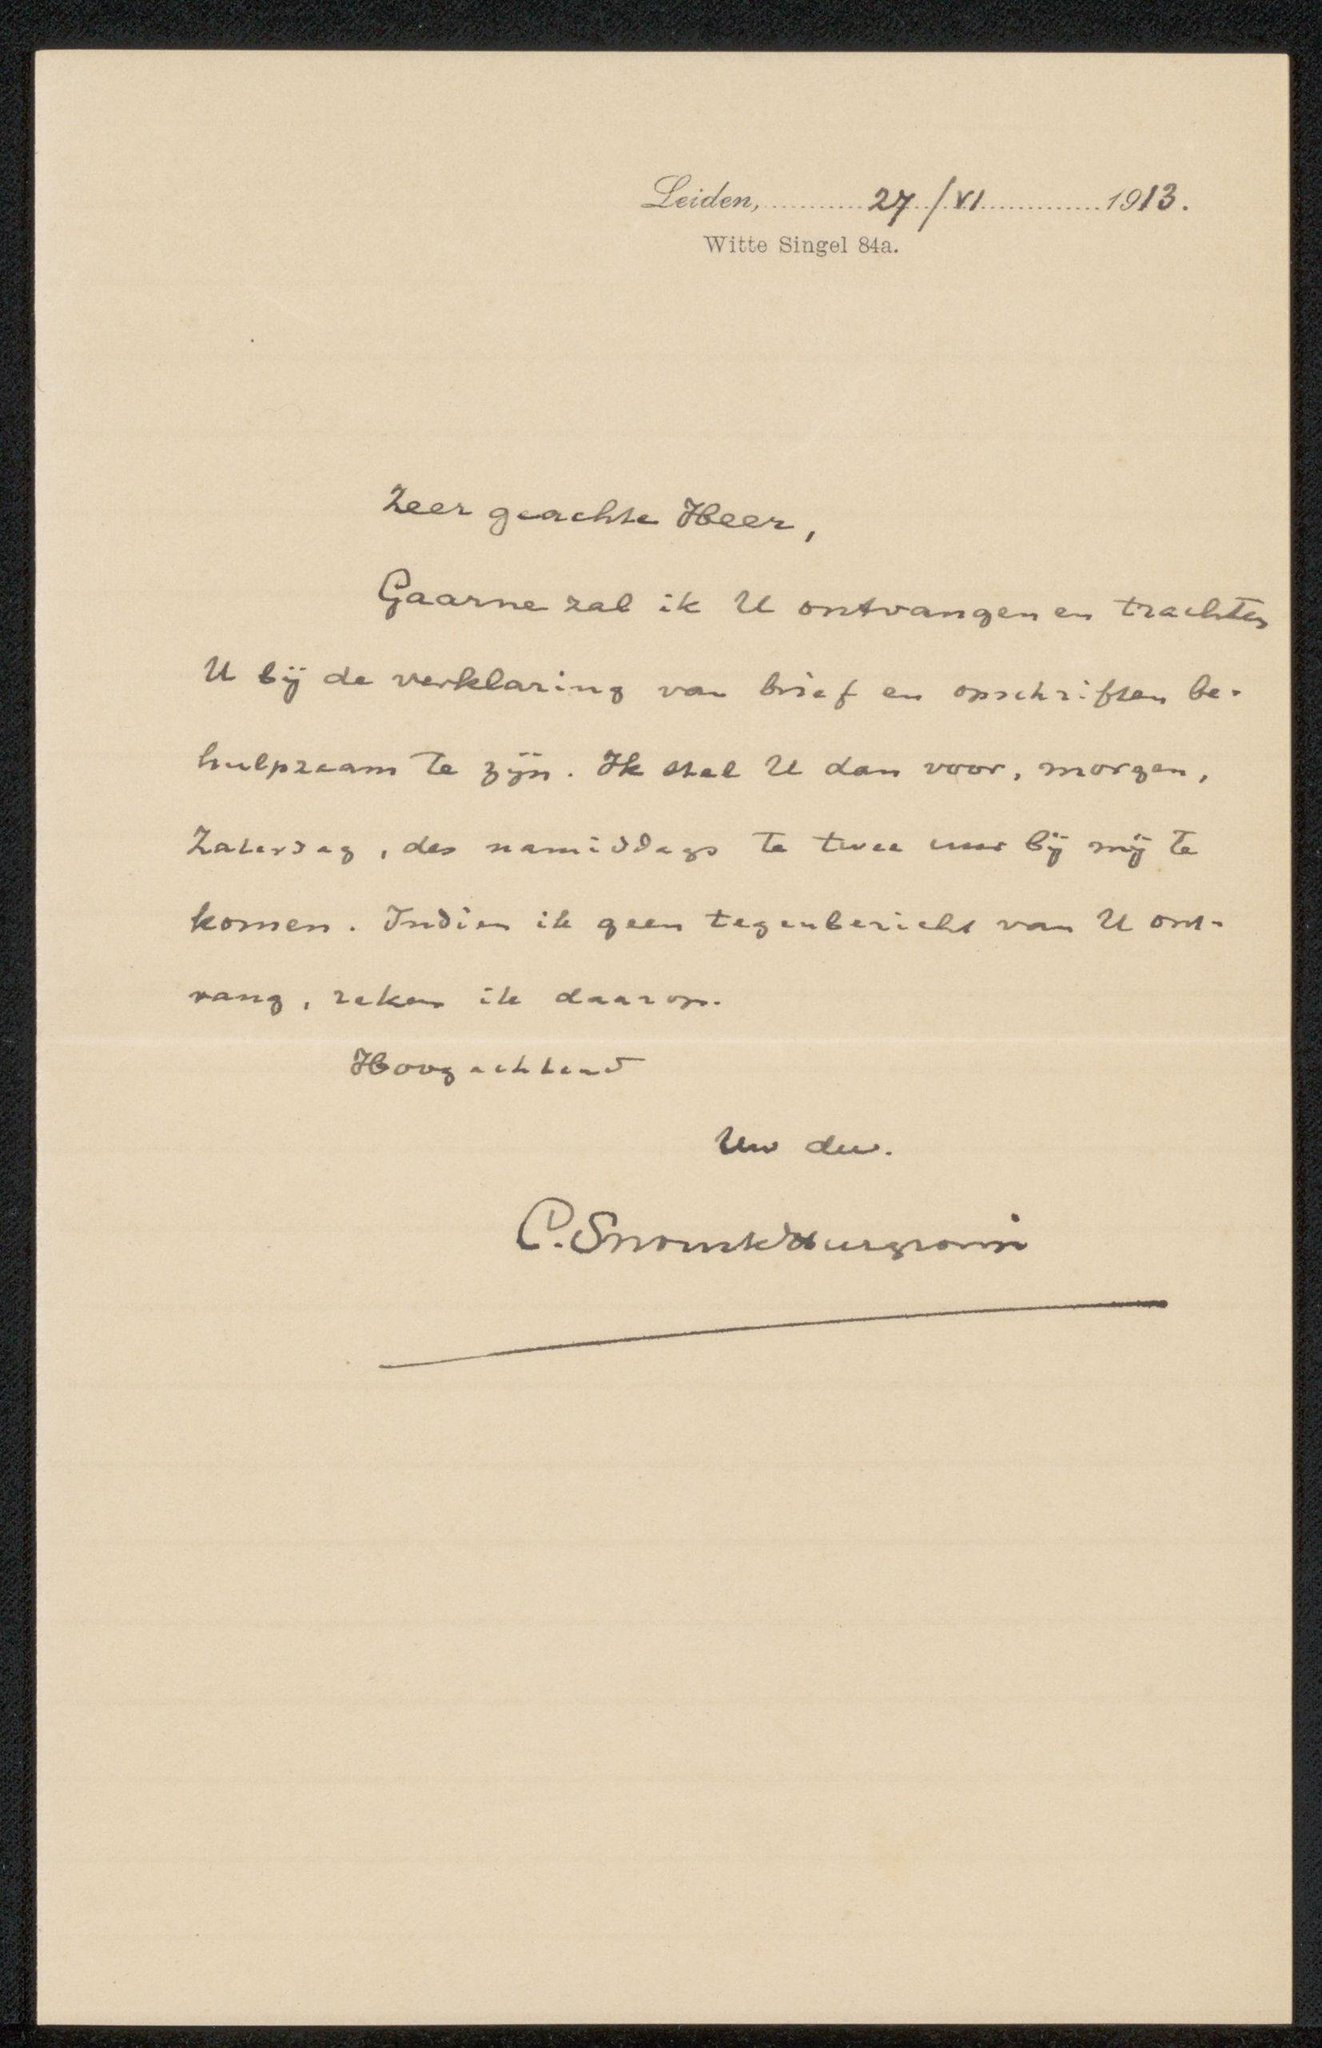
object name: letter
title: Brief aan Philip Zilcken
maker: christiaan snouck hurgronje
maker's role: fotograaf, schrijver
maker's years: 1857-1936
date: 1913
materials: ink, paper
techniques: pen, printing, writing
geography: leiden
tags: the hague, painter, draughtsman, philip zilcken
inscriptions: collector's mark: ‘RPK’